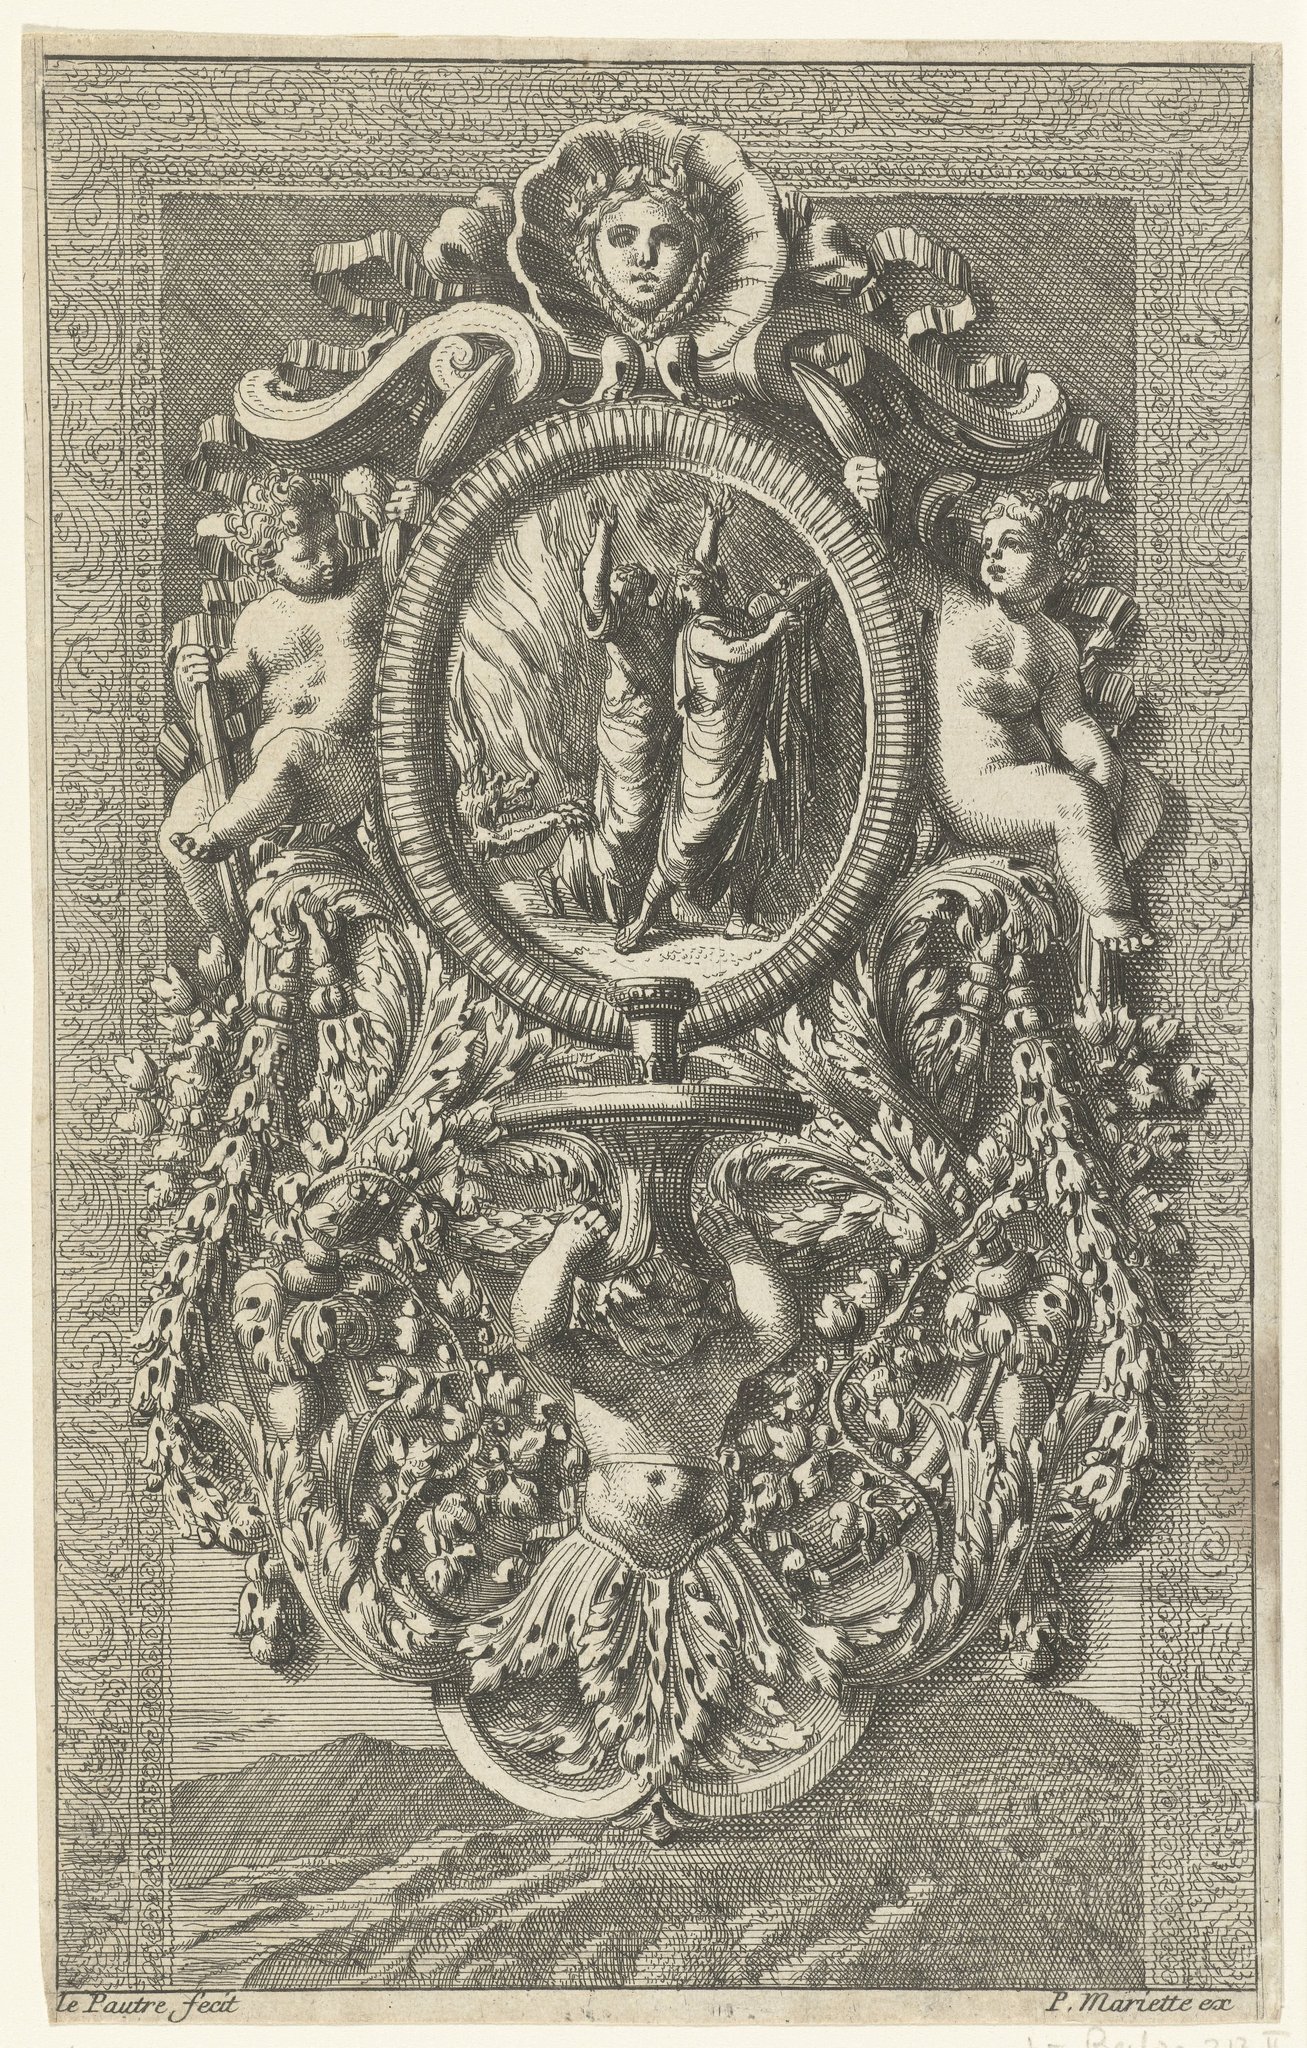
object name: ornament print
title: Differens Desseins pour faire des Plaques et Eaubenistiers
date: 1657-1661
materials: paper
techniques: etching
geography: france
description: Onderaan ontspruit een putto uit bladranken. Blad 5 uit serie van 6 bladen, eerste editie.